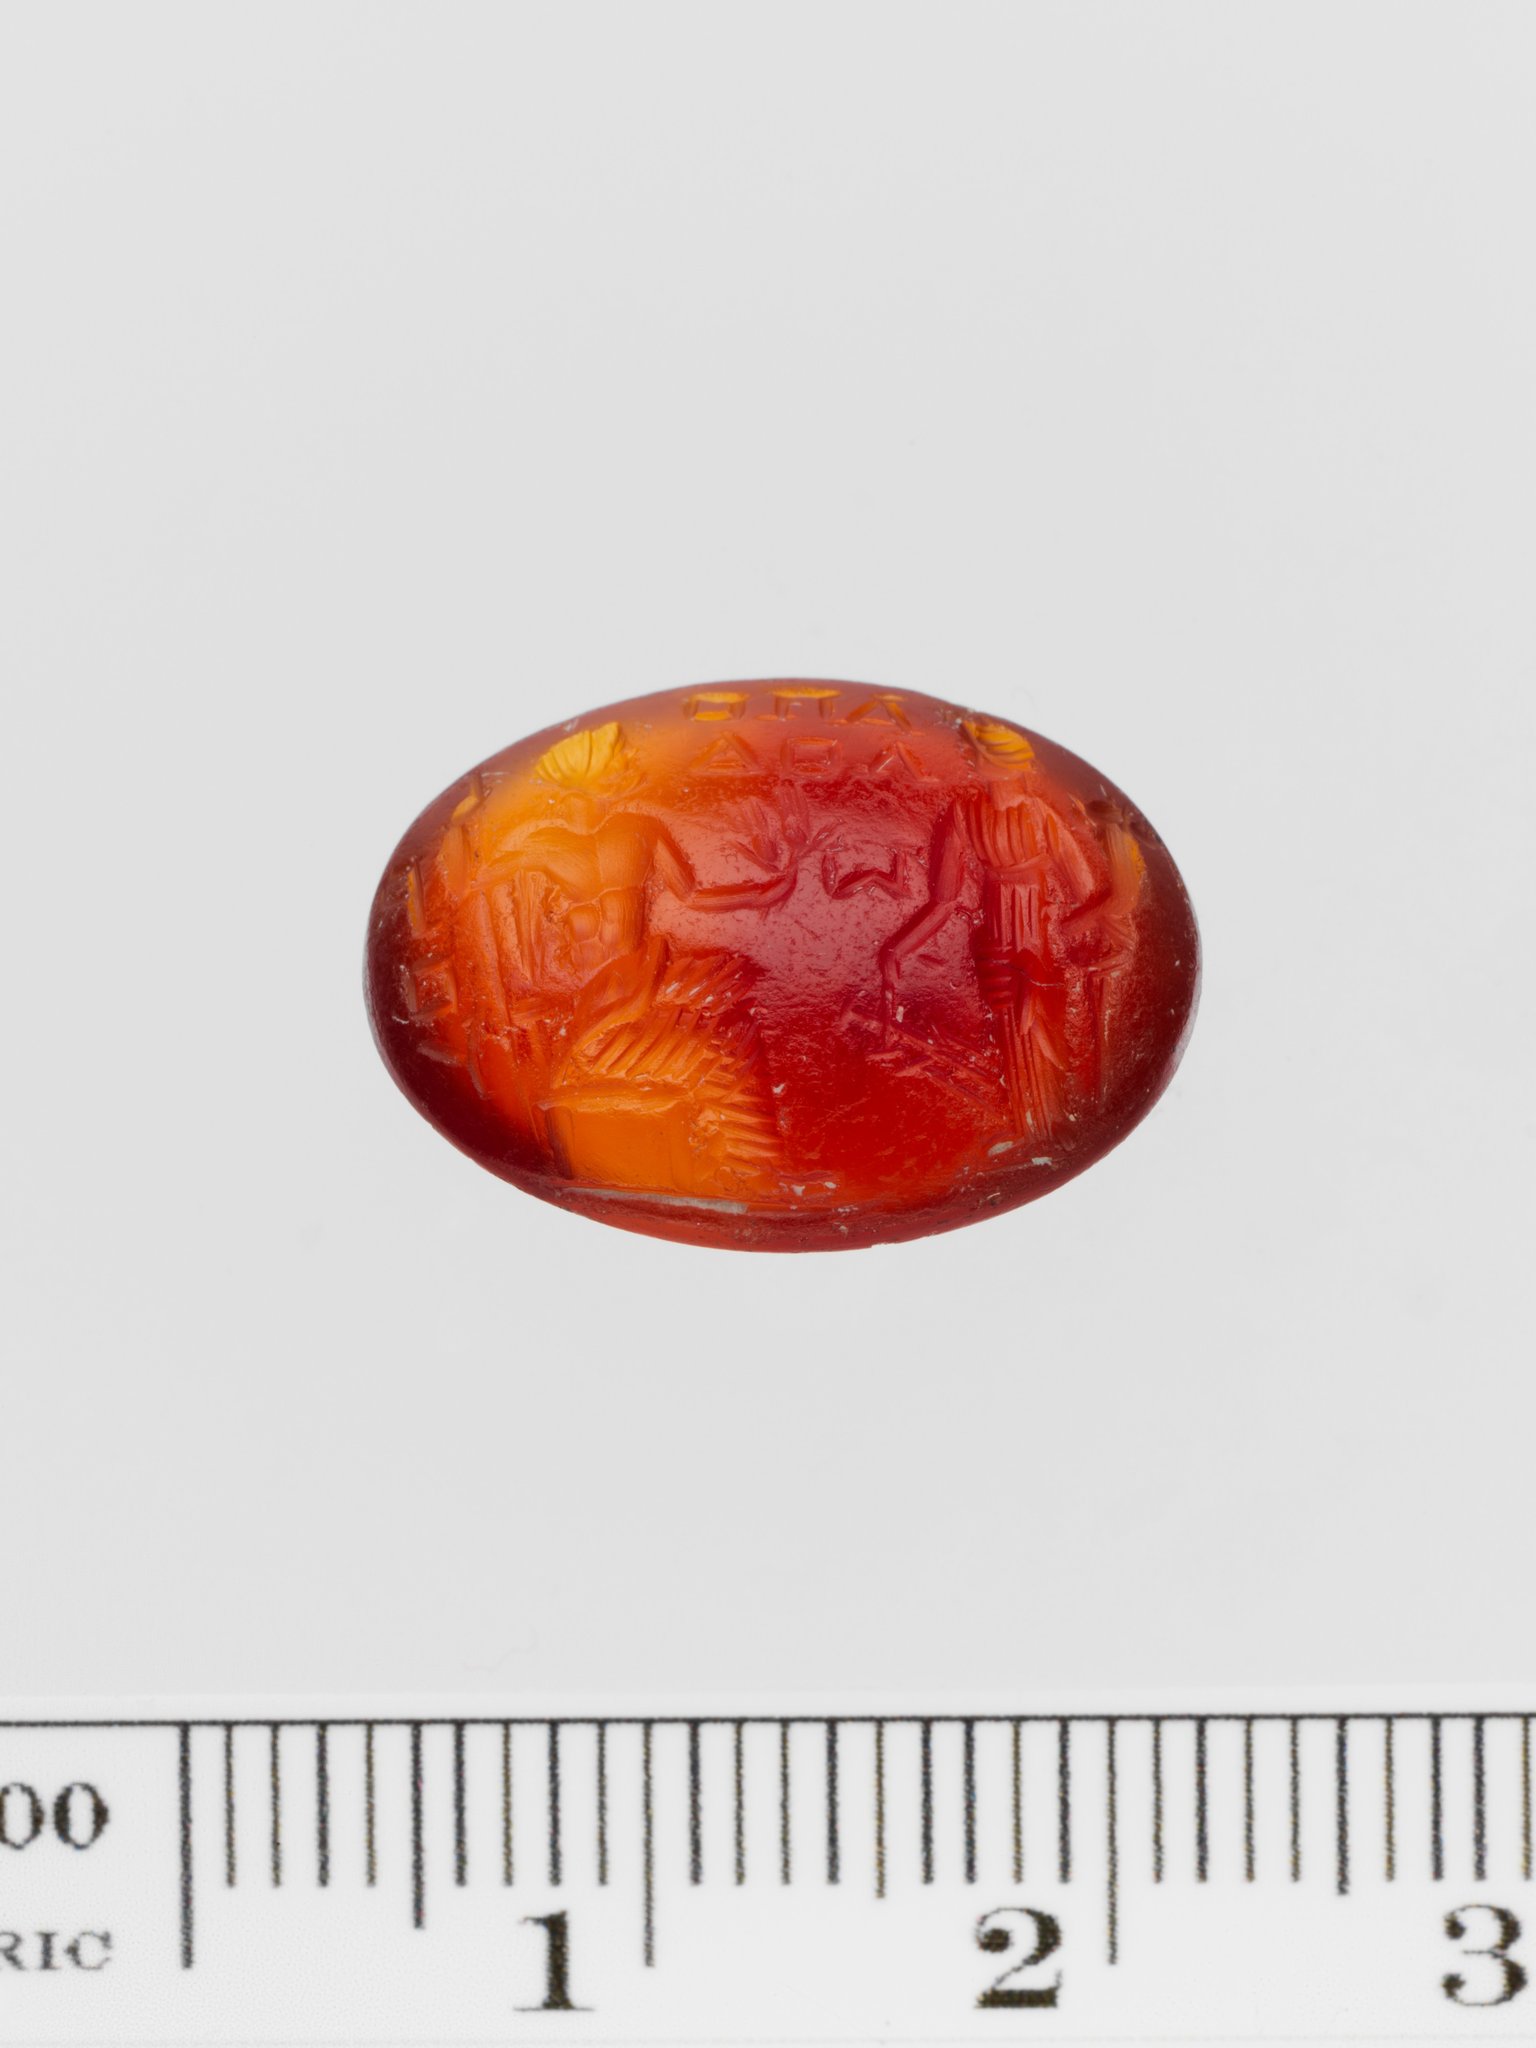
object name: intaglio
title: Carnelian ring stone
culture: roman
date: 101-300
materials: gemstone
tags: men,women